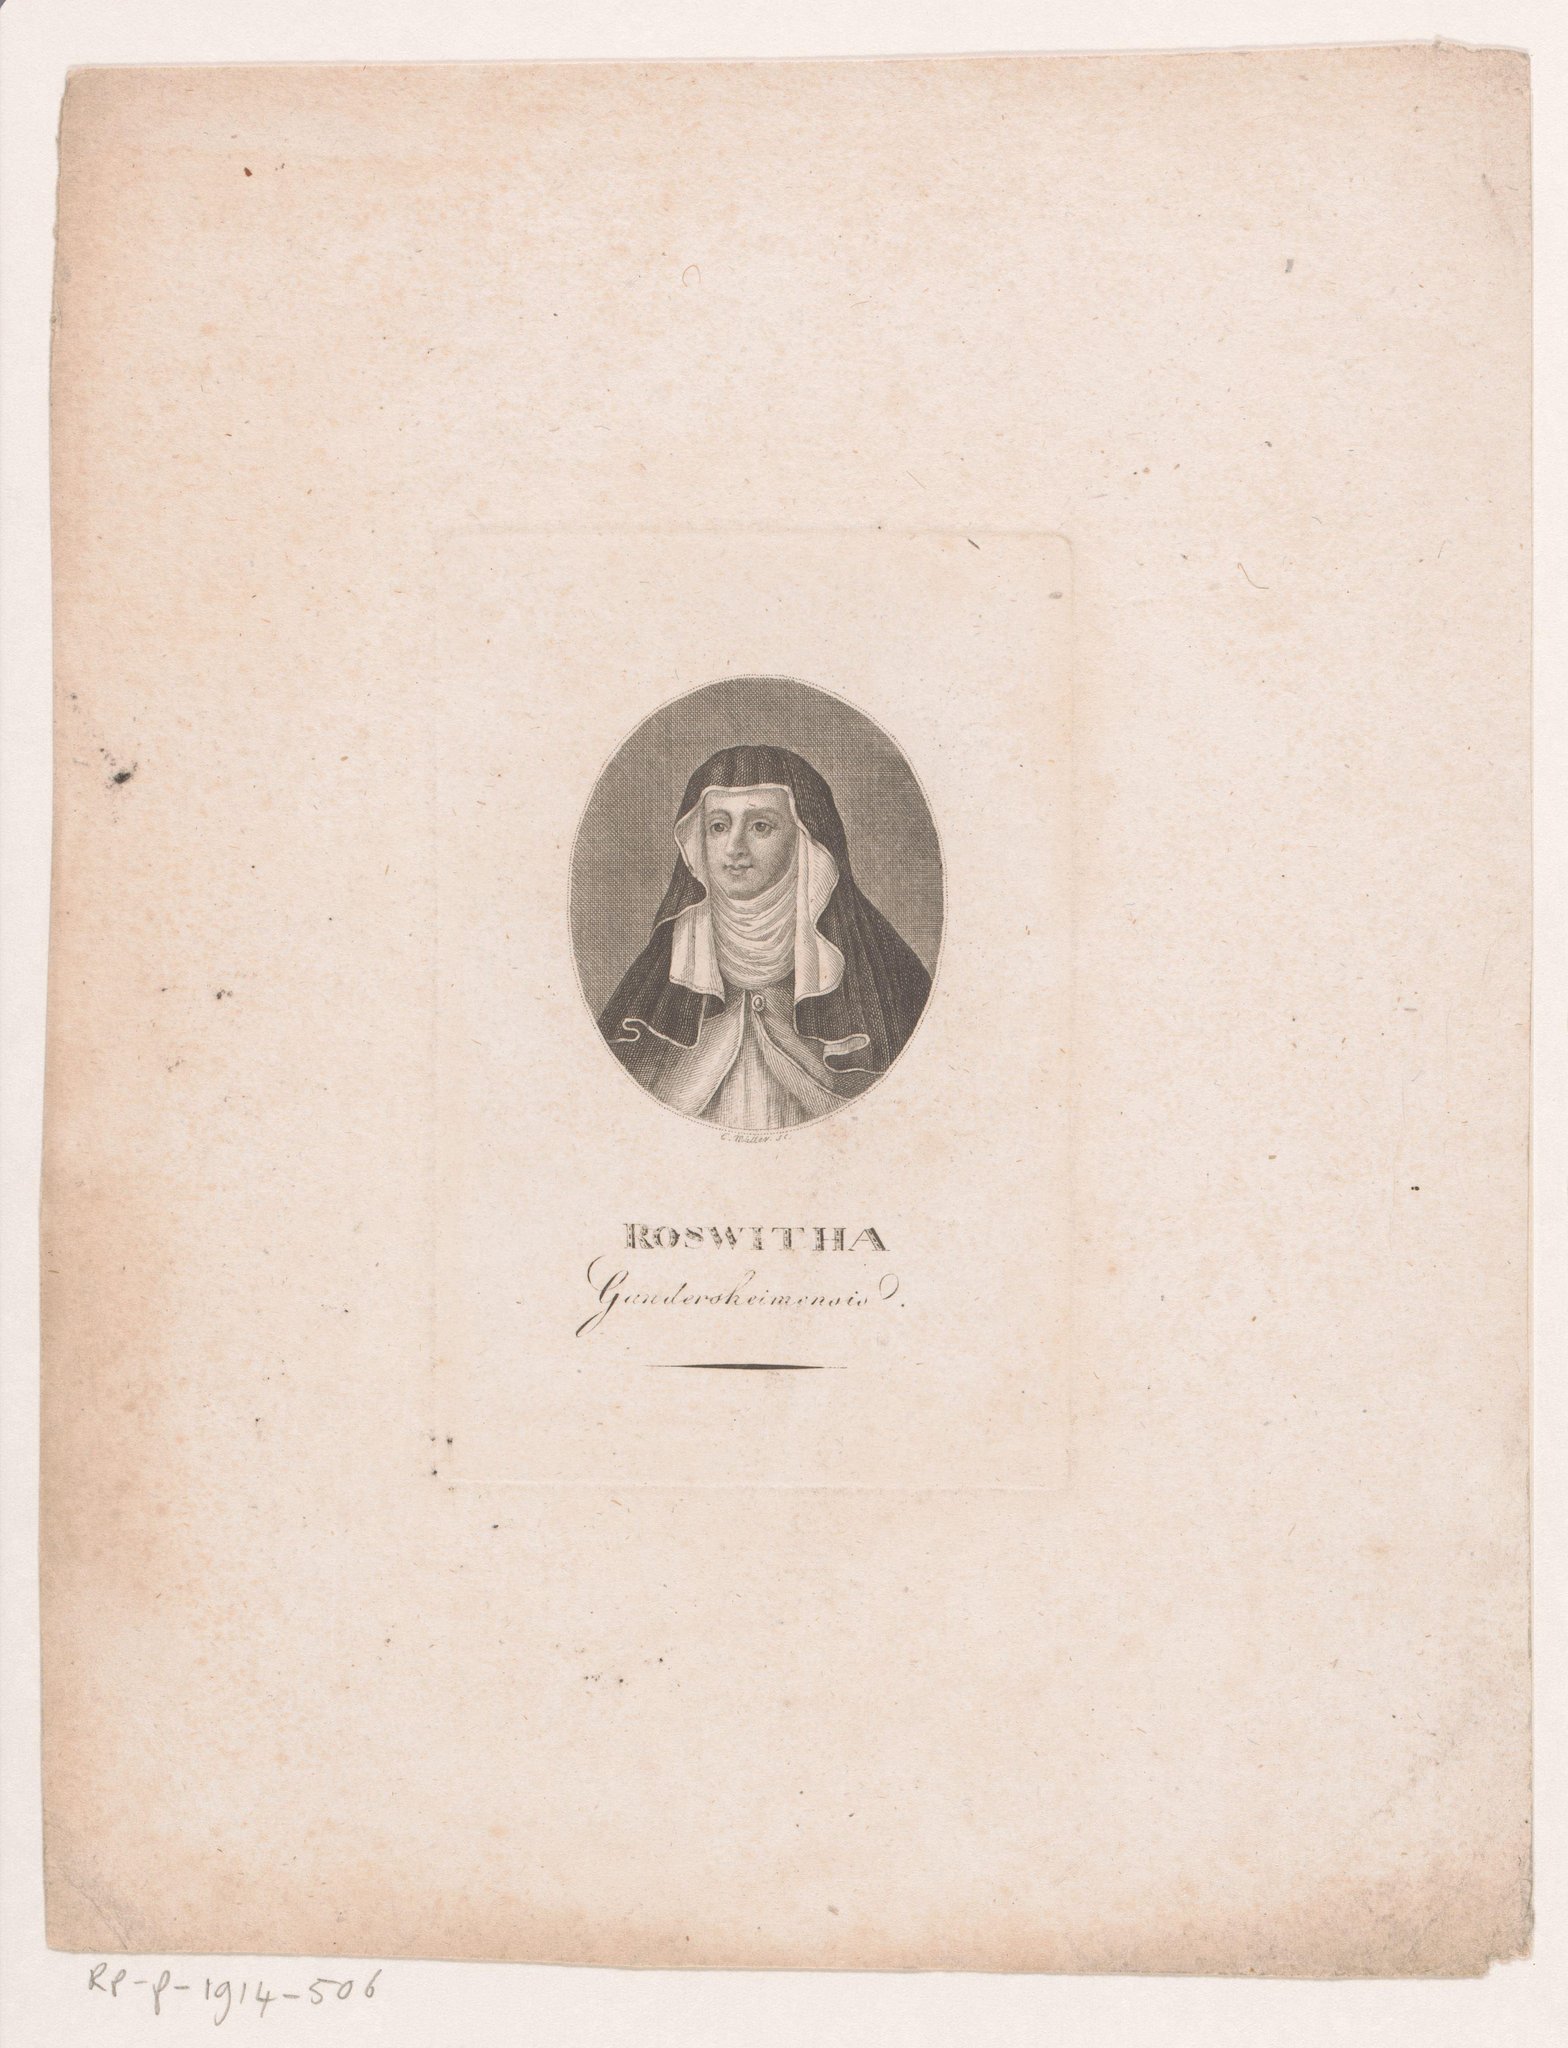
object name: print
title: Portret van Roswitha van Gandersheim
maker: johann christian ernst müller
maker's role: draughtsman, print maker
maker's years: 1766-1824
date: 1776-1824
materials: paper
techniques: etching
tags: historical persons - bb - woman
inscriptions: collector's mark: Lugt 2228